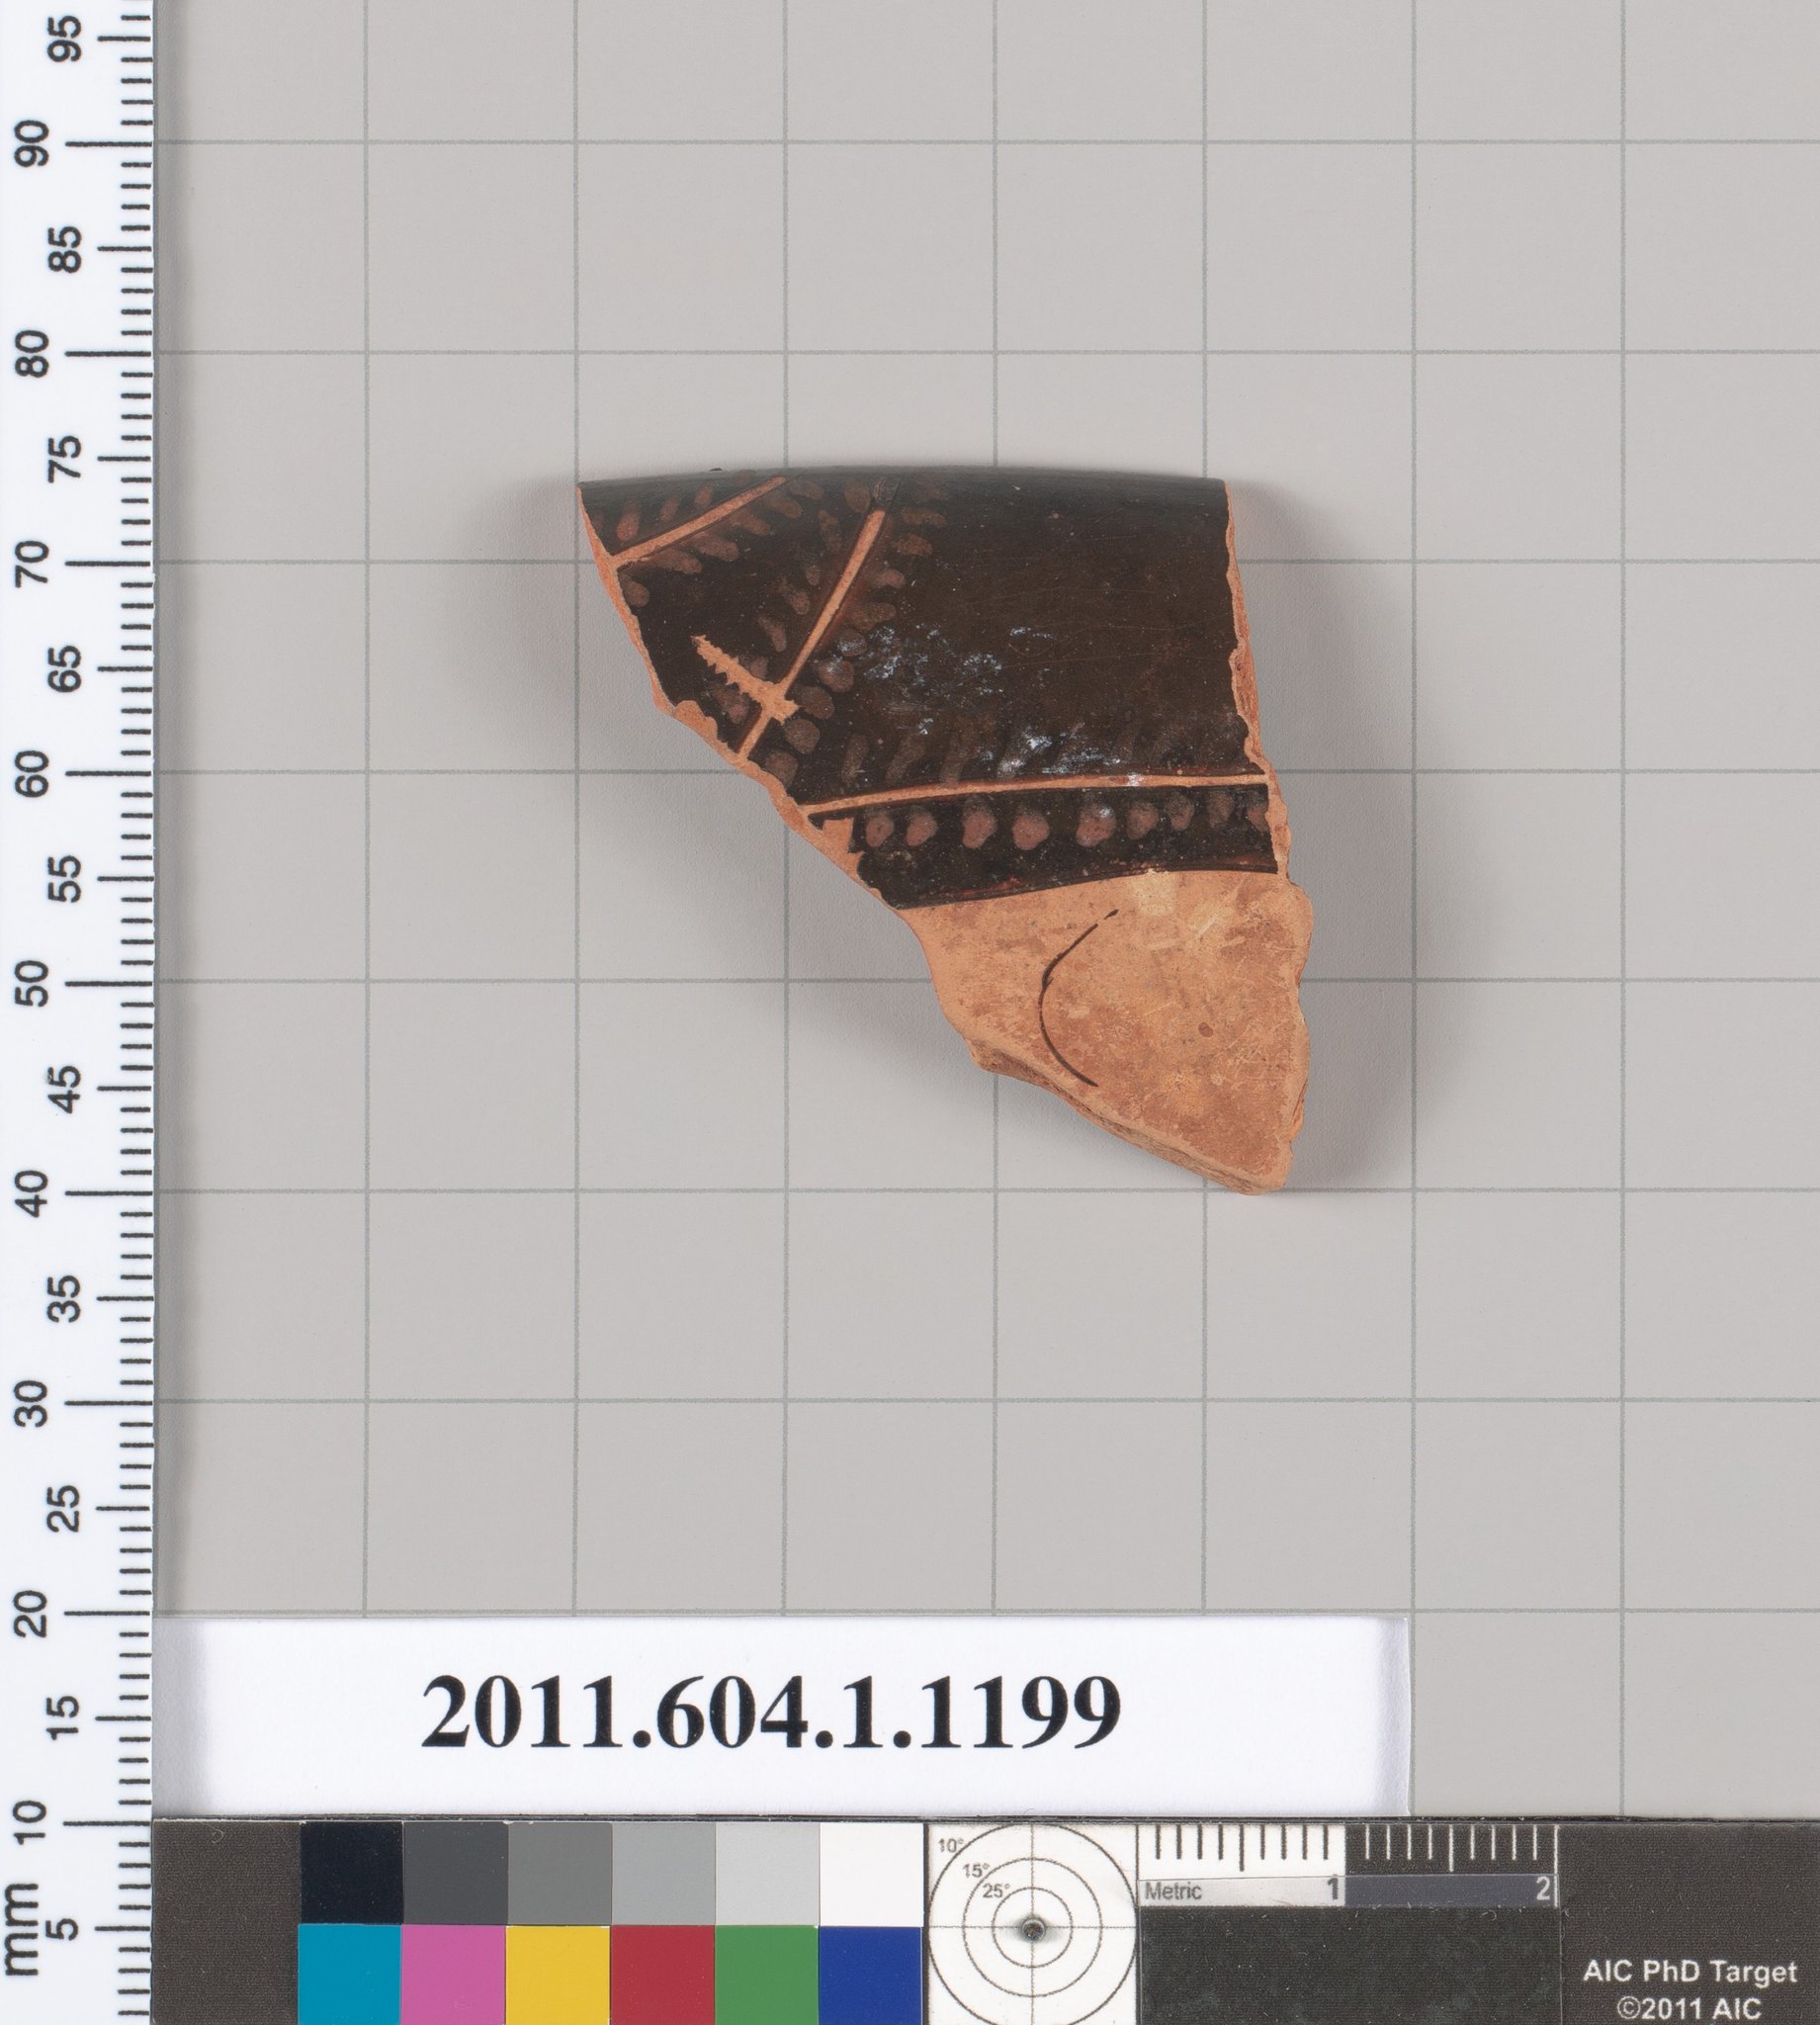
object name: kylix fragment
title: Terracotta rim fragment of a kylix (drinking cup)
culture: greek, attic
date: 490-480 BCE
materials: terracotta